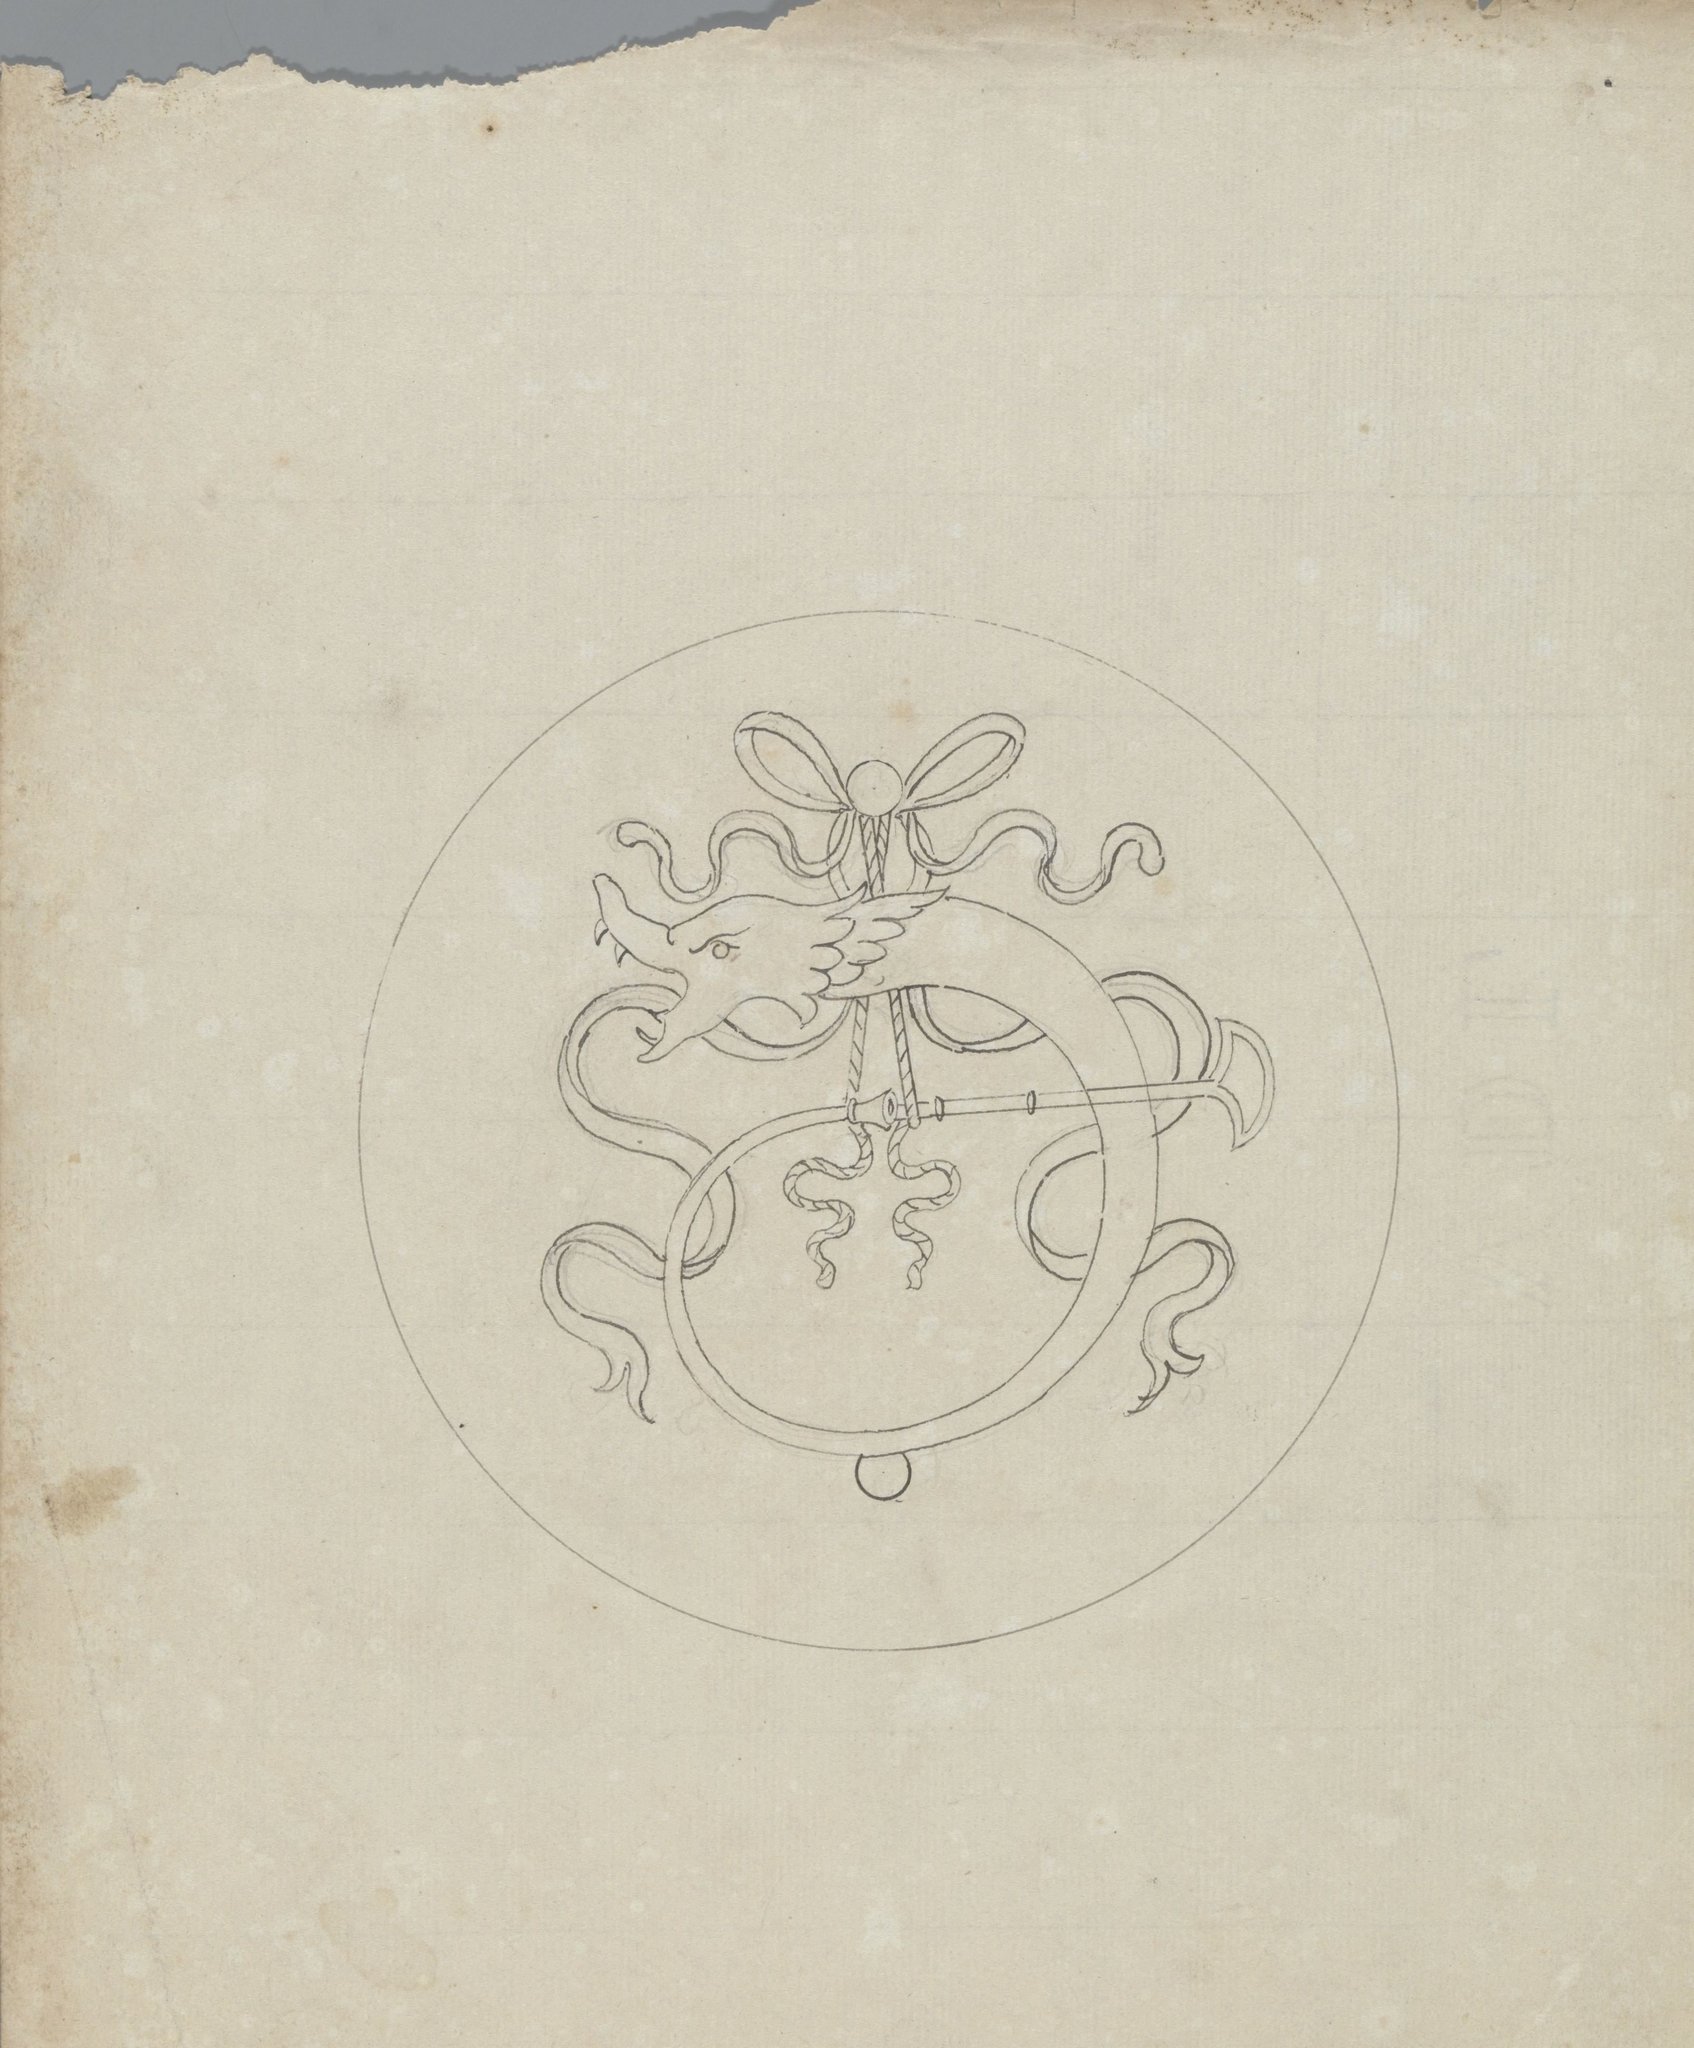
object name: design drawing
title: Ontwerp voor marqueterie van aan linten opgehangen muziekinstrument(en) in rond medaillon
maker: pierre félix van doren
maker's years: 1797-1856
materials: graphite, ink, paper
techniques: pen in black ink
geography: brussels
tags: trophy, i.e.: decorative arrangement of symbolic or typical objects ~ ornament, horn, trumpet, cornet, trombone, tuba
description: Een van 103 ontwerpen voor marqueterie van aan linten opgehangen muziekinstrumenten in ronde medaillons, bestemd voor de set stoelen gemaakt door Van Doren voor de grote zaal van het Paleis van de Prins van Oranje in Brussel in 1828.